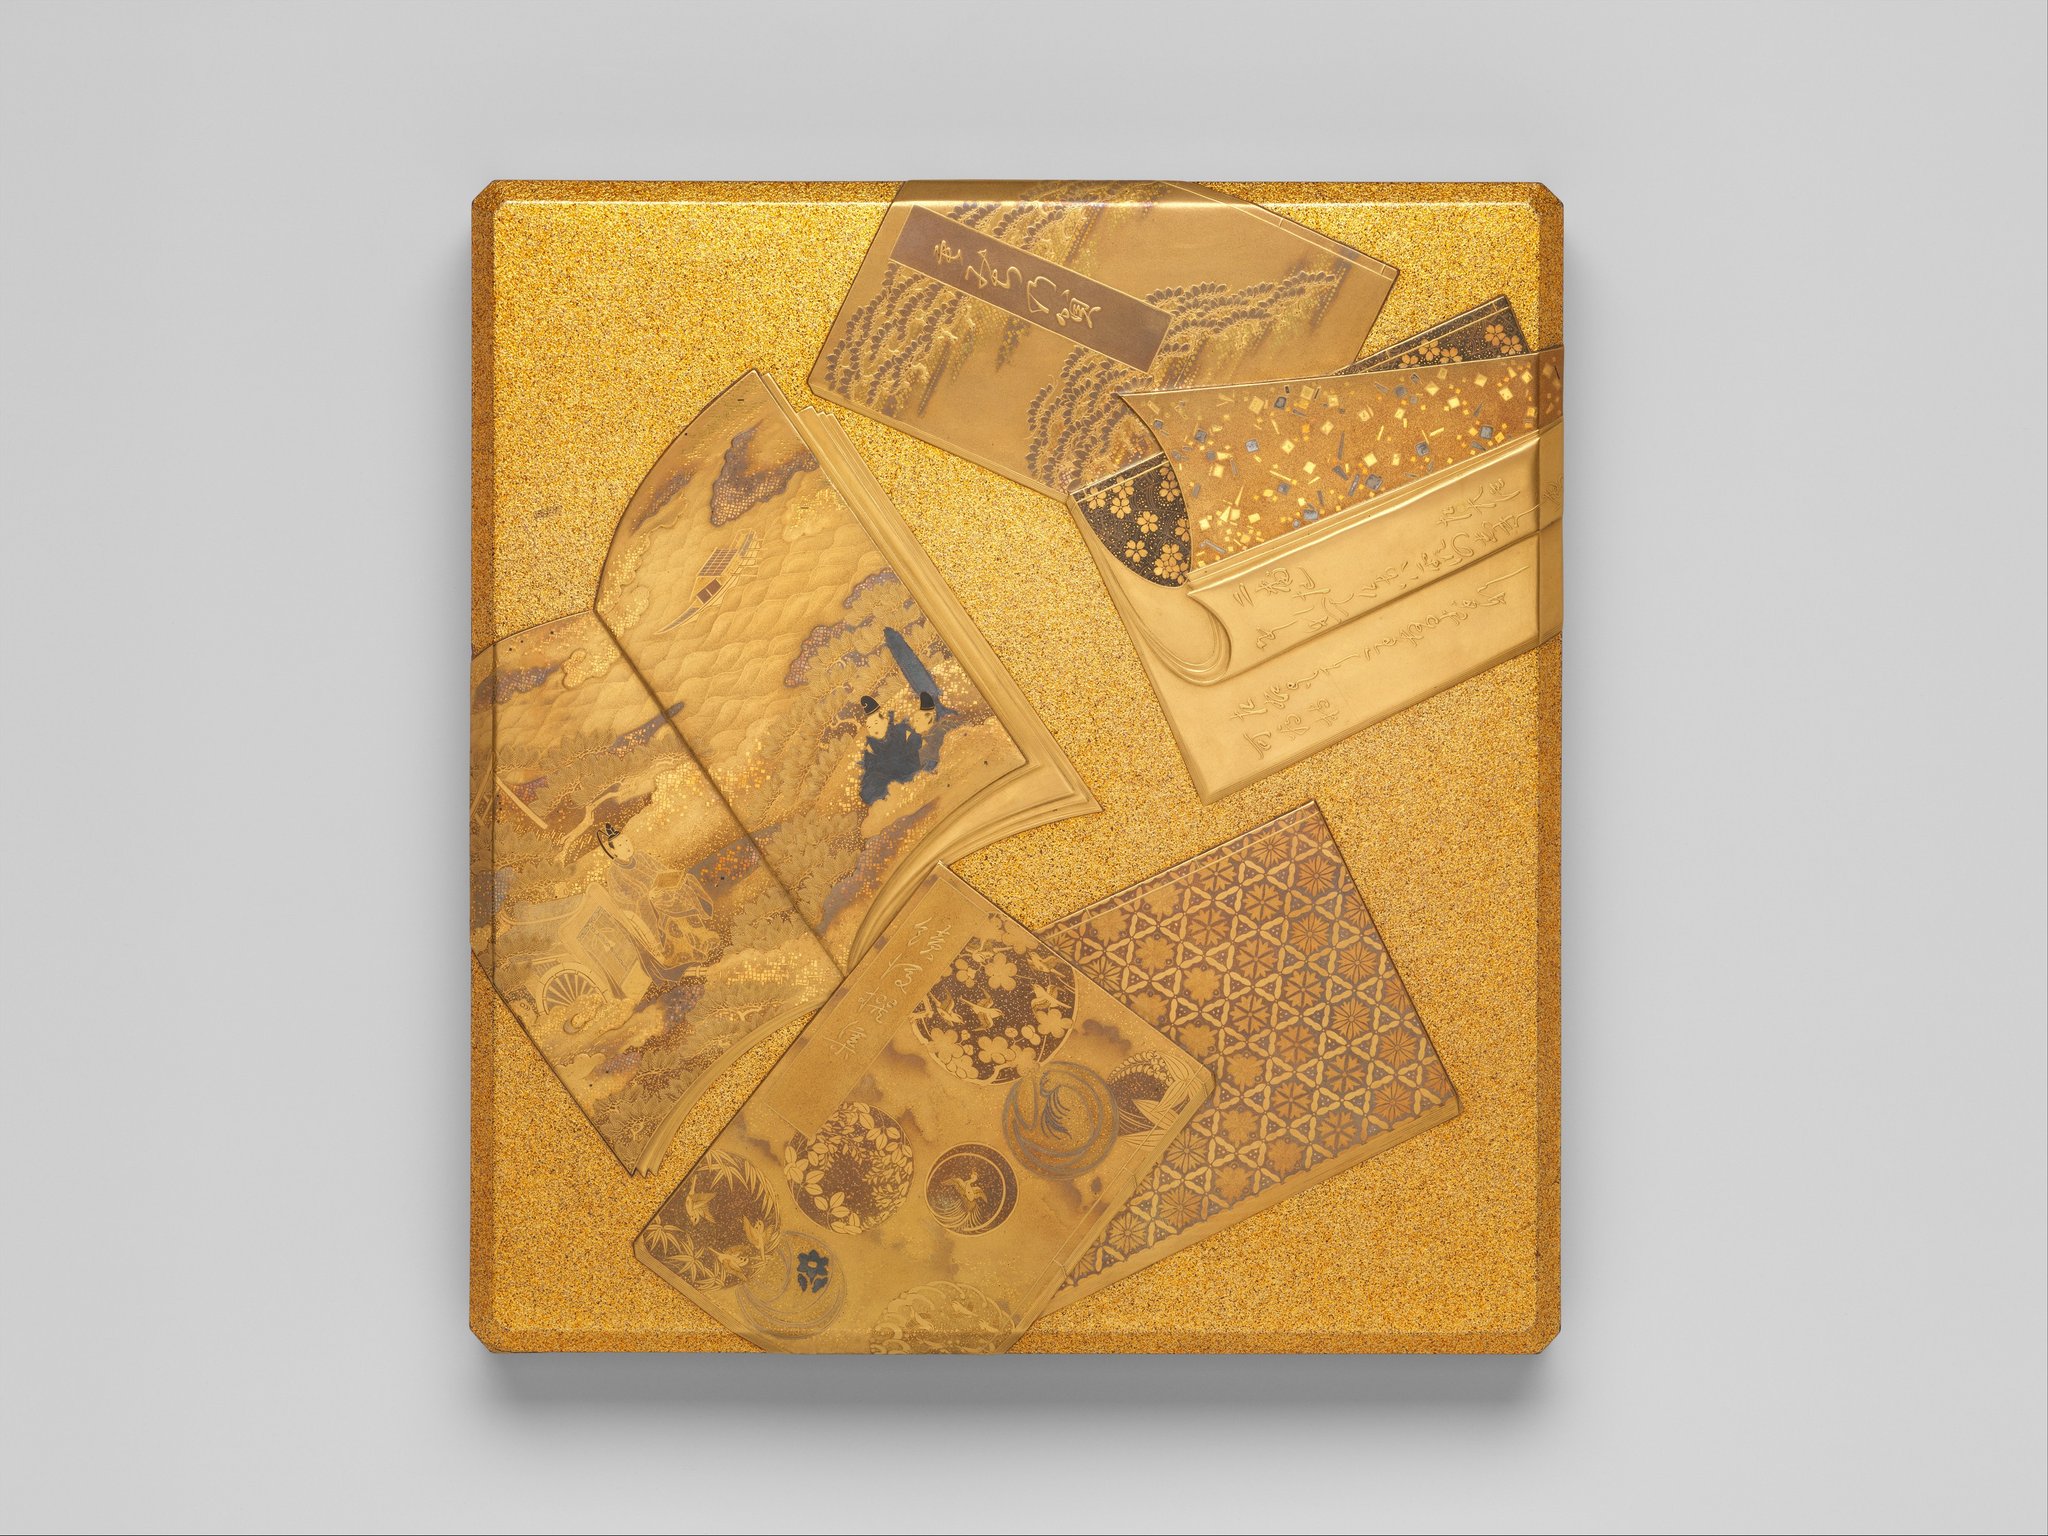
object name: writing box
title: Writing Box (Suzuribako) with Books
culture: japanese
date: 1701-1800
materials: gold, gold foil, silver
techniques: cutting, hiramakie, maki-e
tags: books